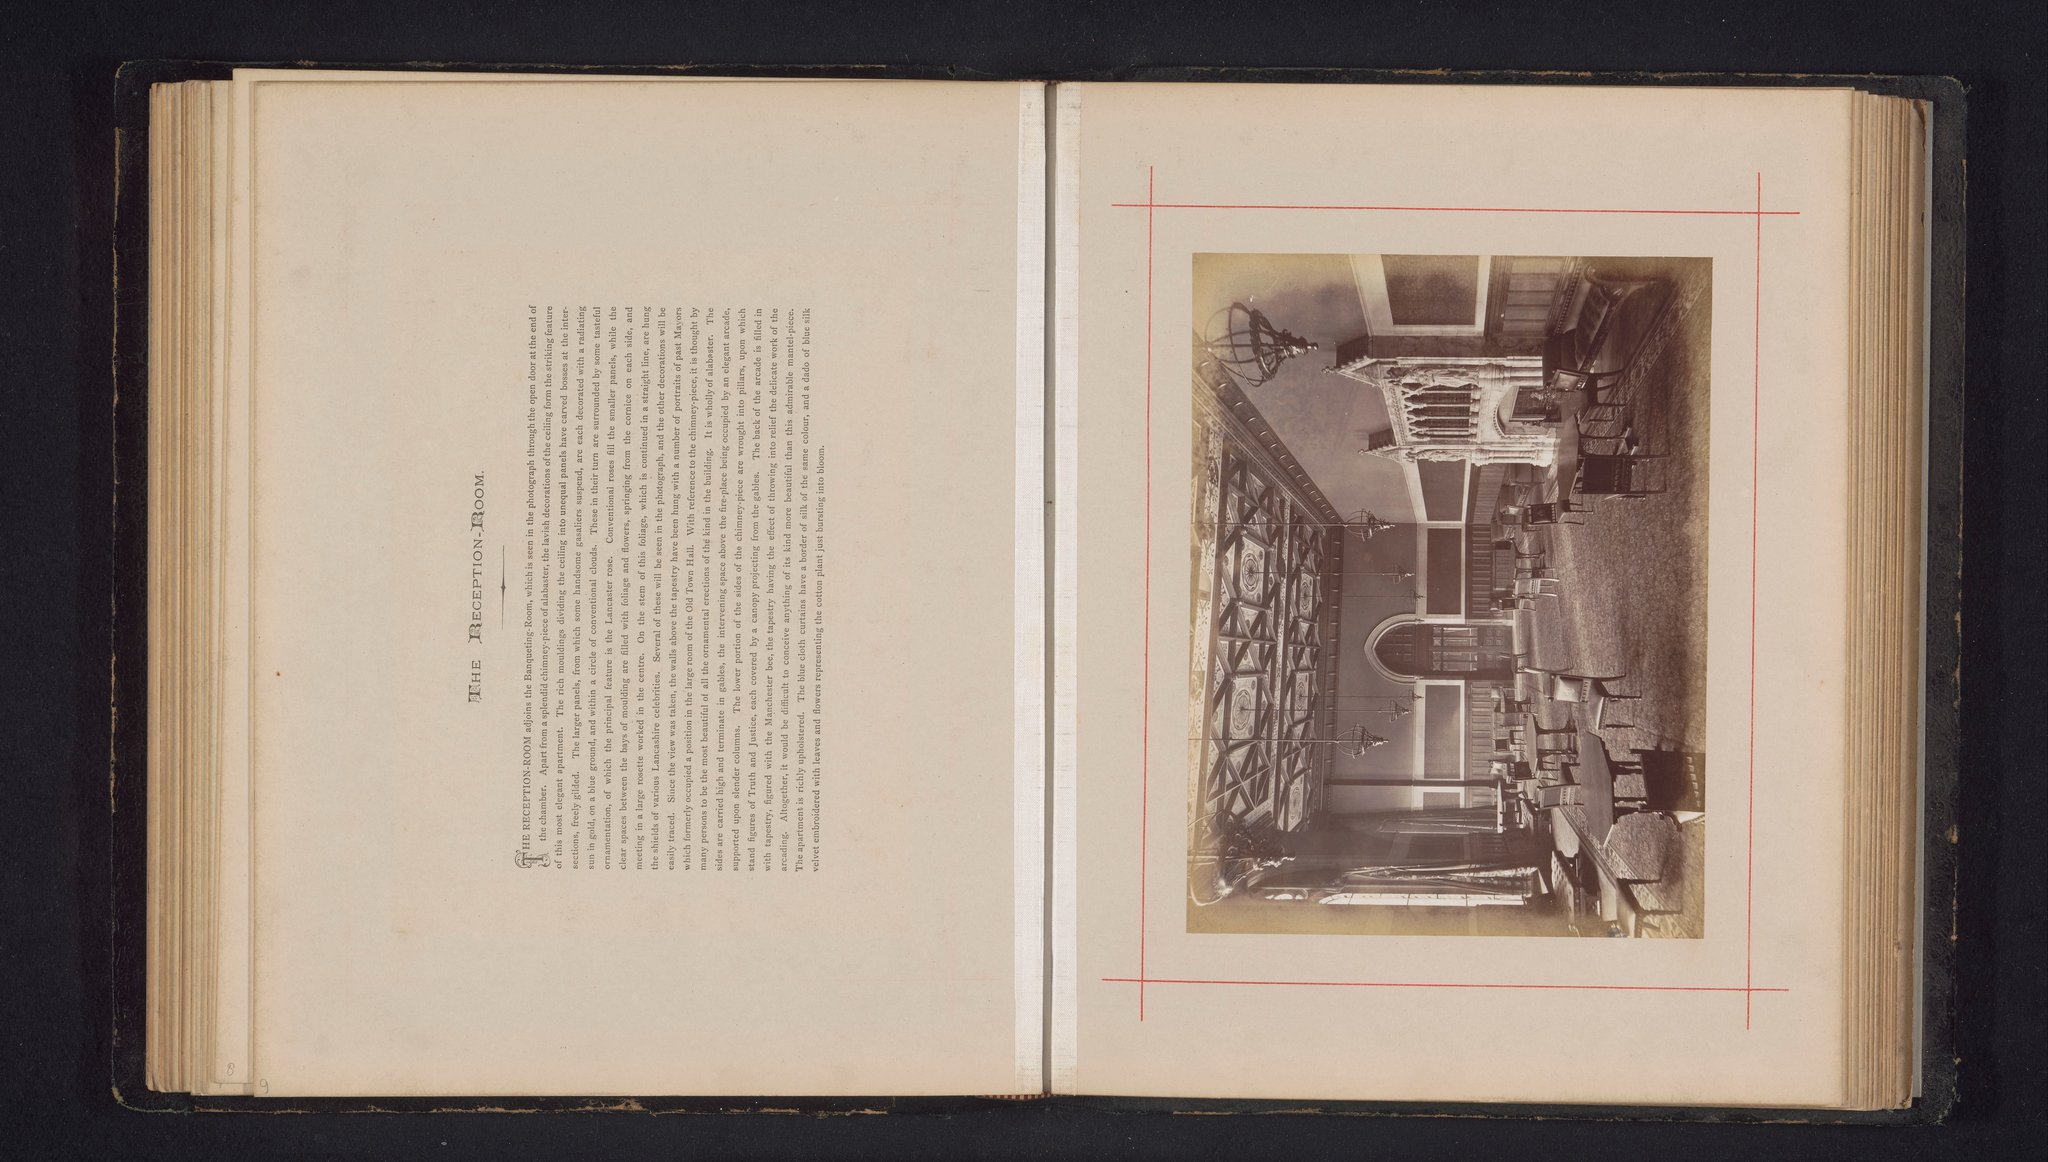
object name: page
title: Receptiekamer in het Stadhuis van Manchester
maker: j. mcleod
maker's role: fotograaf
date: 1877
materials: photographic support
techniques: albumen print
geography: manchester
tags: townhall, interior ~ representation of a building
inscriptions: title: ‘The Reception-Room’